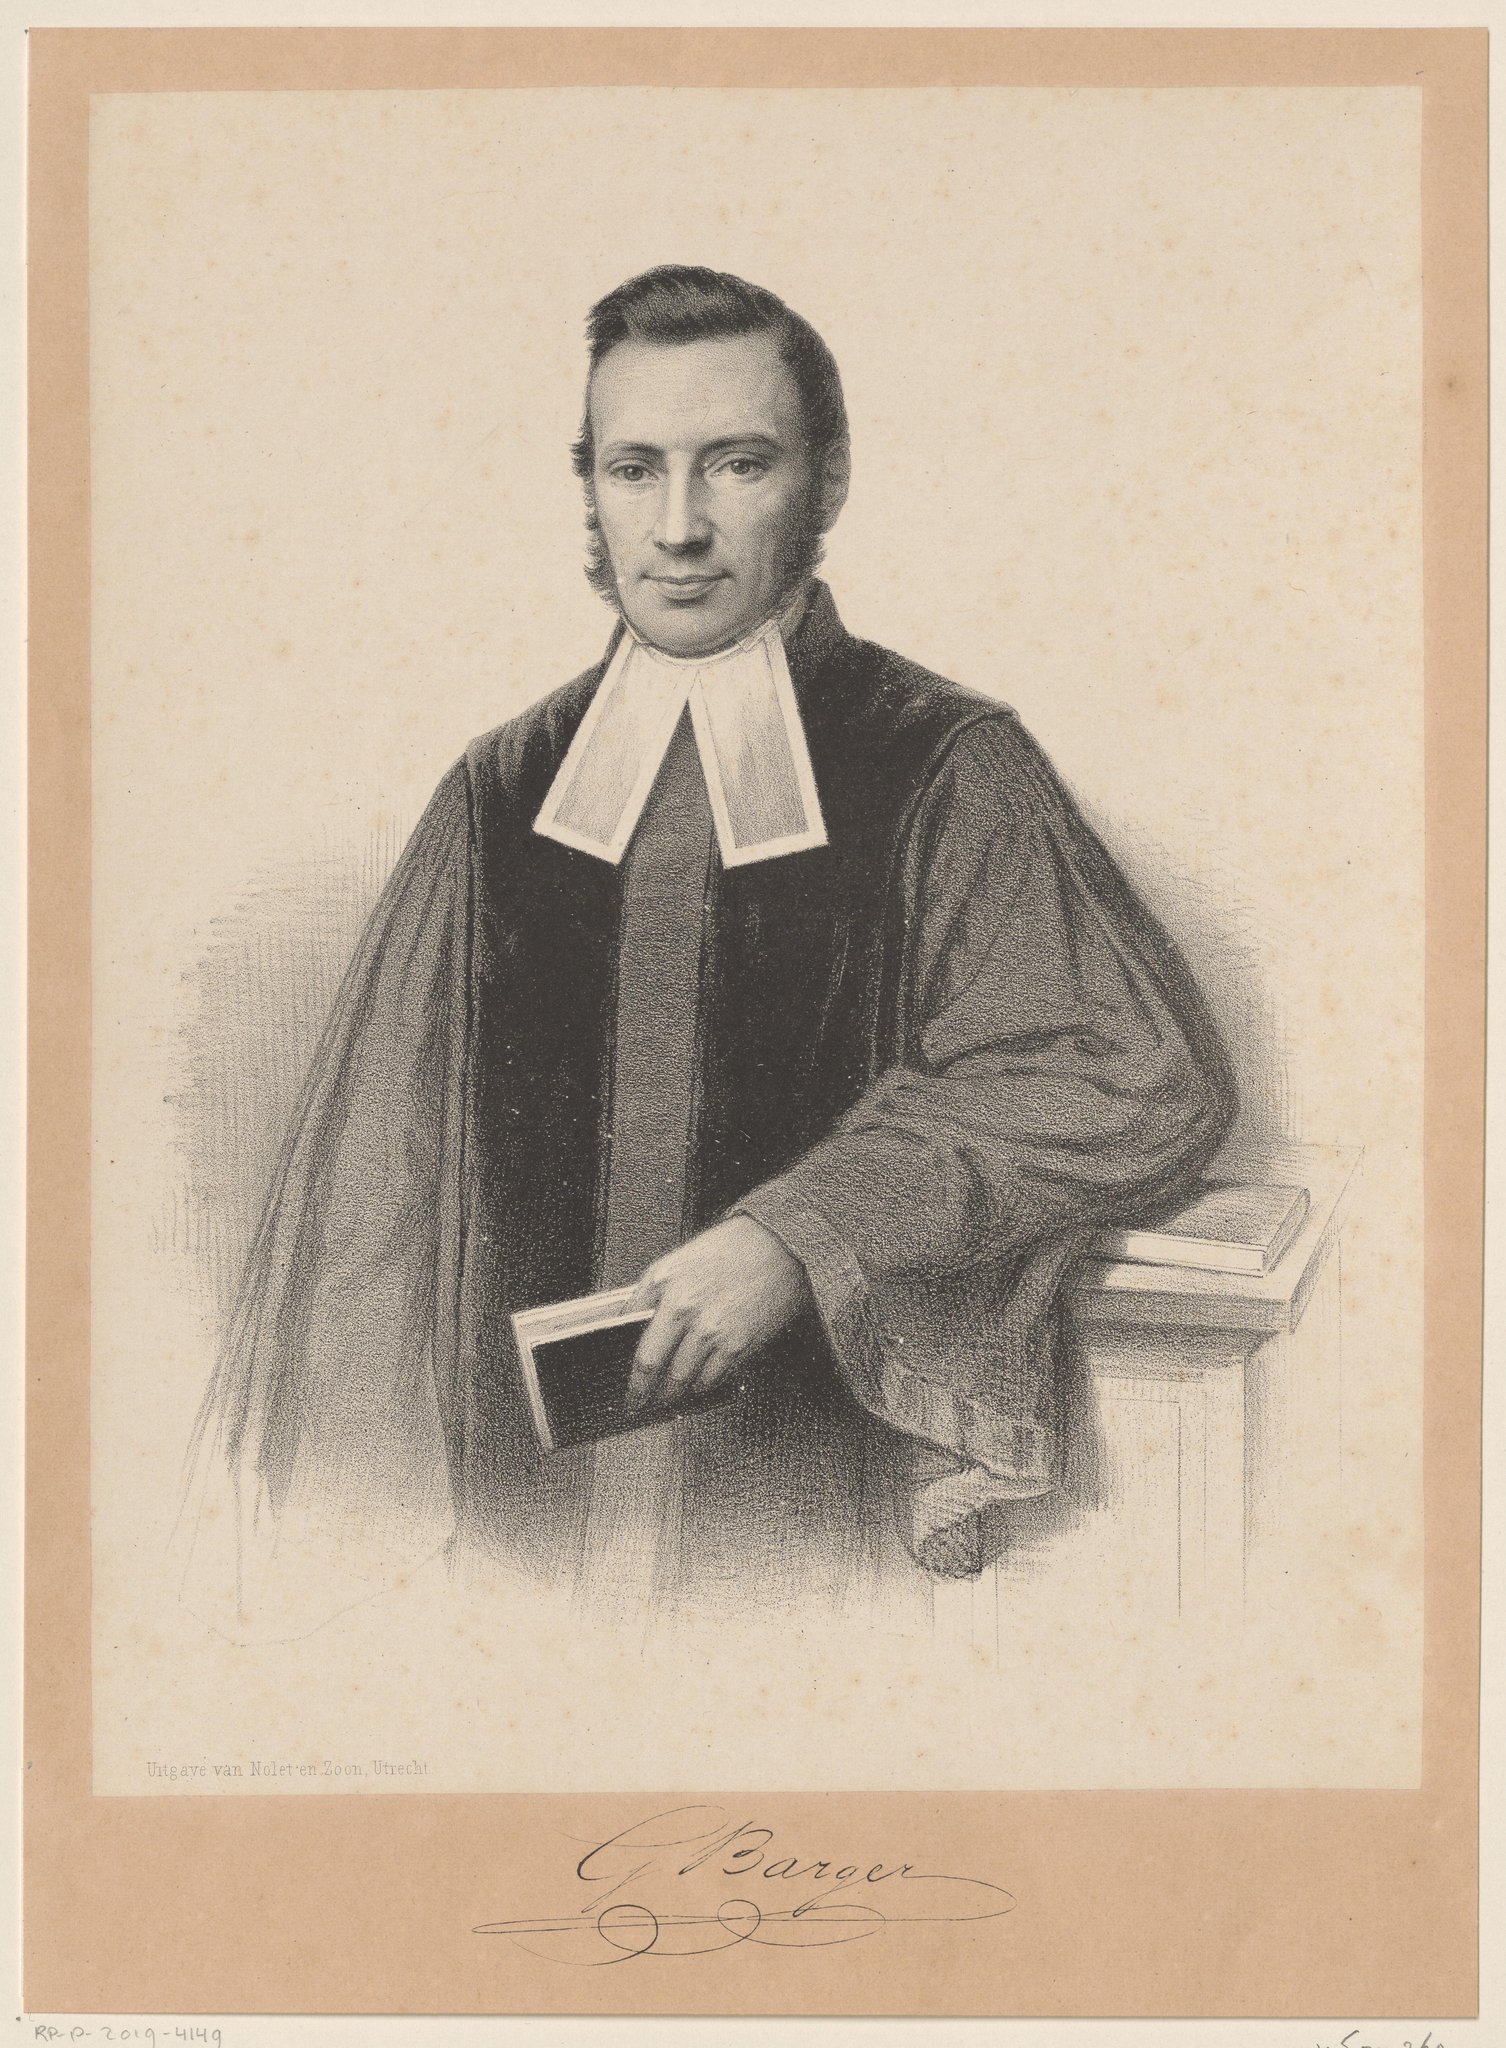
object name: print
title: Portret van Gerrit Barger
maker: Anonymous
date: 1857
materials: paper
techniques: lithograph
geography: utrecht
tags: historical persons, book